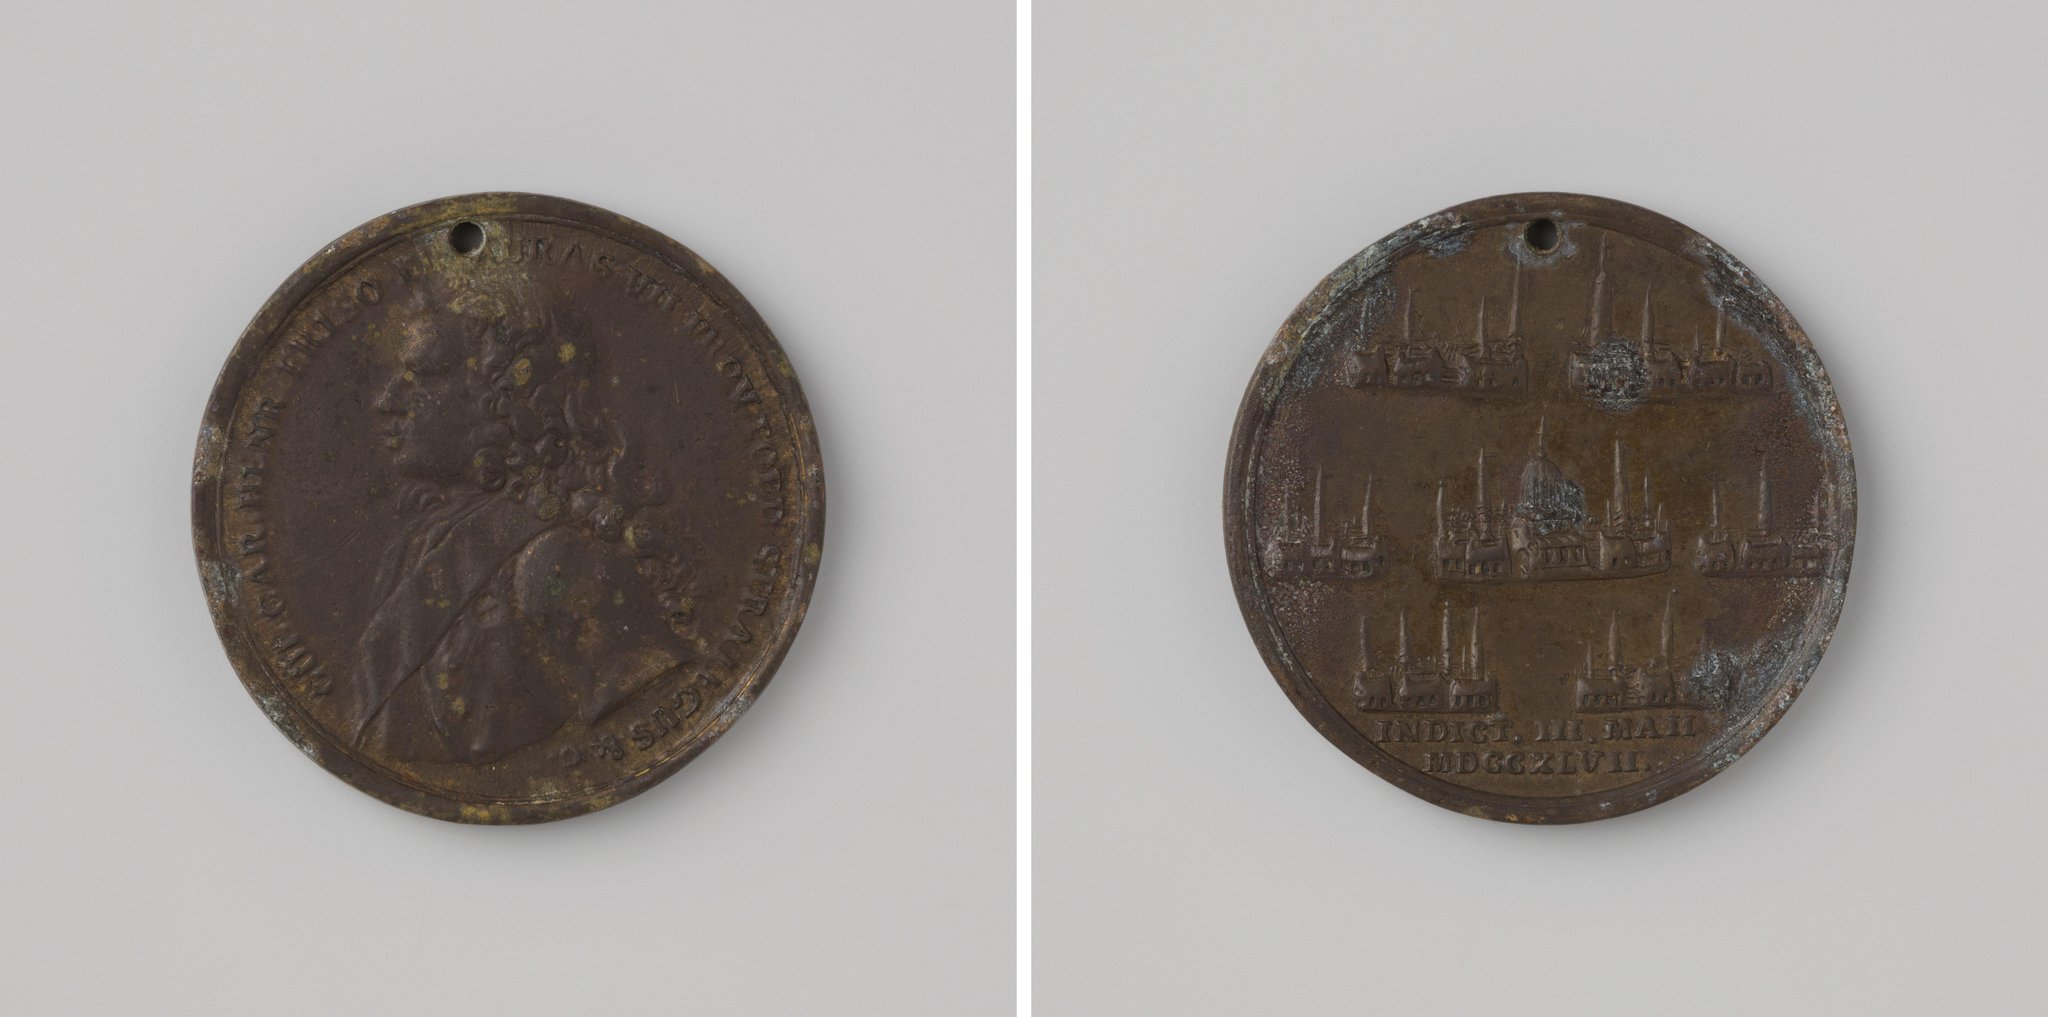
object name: history medal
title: Verheffing van Willem IV, prins van Oranje-Nassau, tot admiraal en kapitein-generaal der Verenigde Nederlanden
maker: Anonymous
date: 1747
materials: copper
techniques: striking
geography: netherlands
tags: the hague, willem iv (prins van oranje-nassau)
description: Koperen penning met gat erin. Voorzijde: borststuk man naar links binnen omschrift. Keerzijde: gezicht op zeven steden boven opschrift